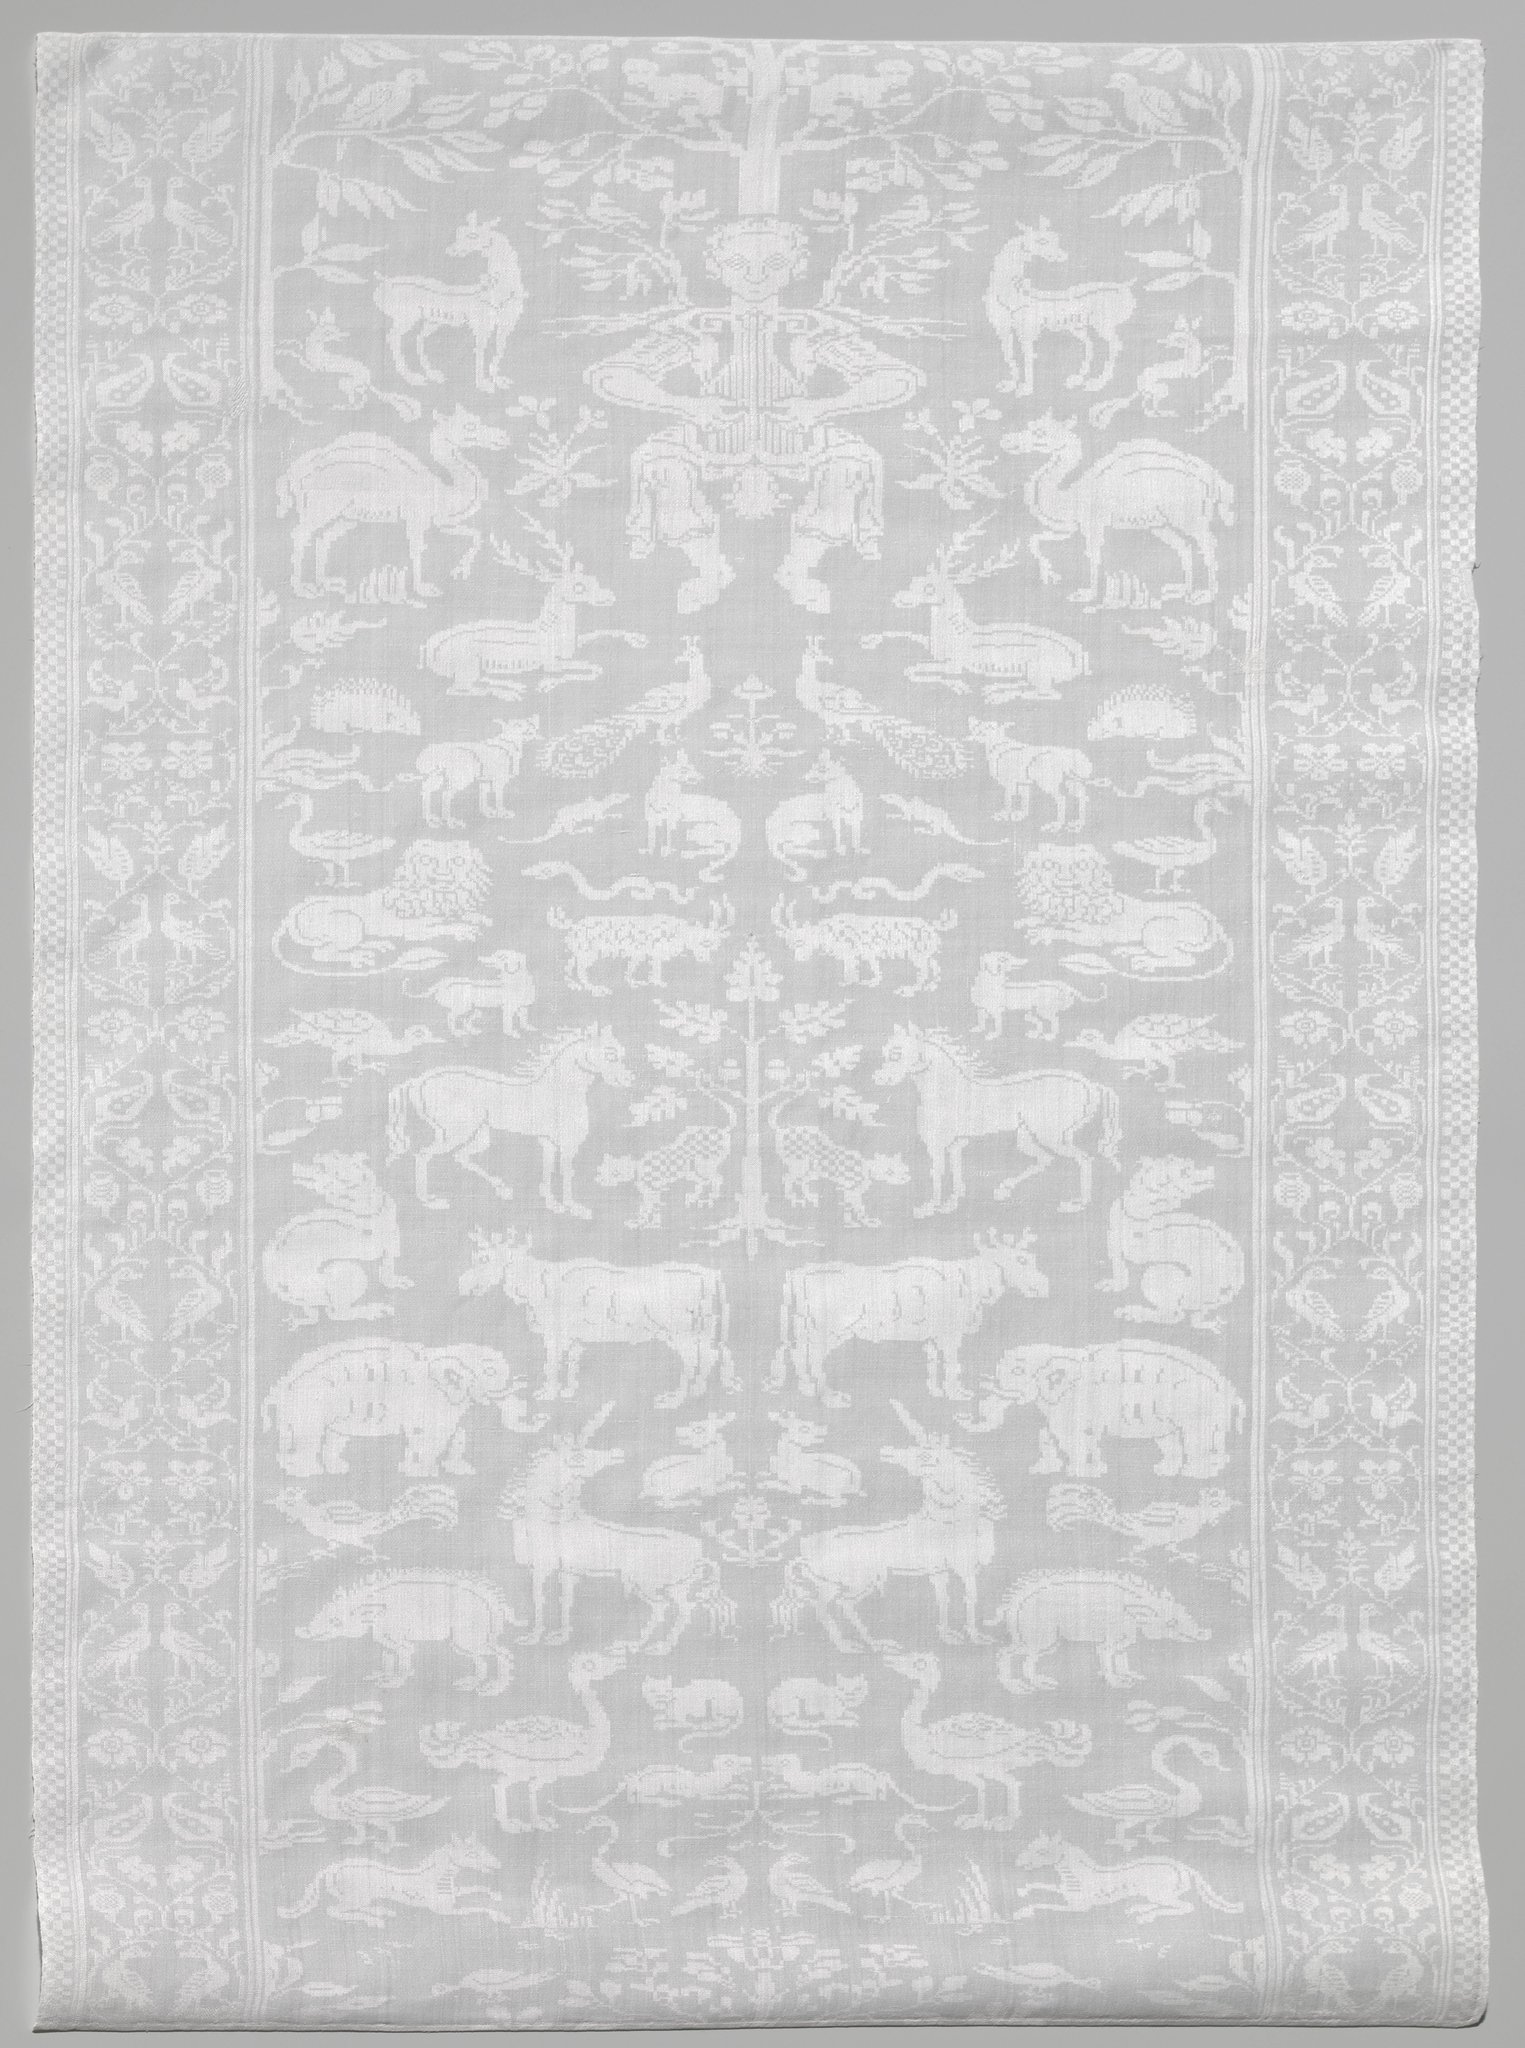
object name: napkin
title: Servet van wit linnendamast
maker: Anonymous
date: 1600-1625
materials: linen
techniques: damask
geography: northern netherlands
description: Wit linnen damasten servet met Orpheus en de dieren.